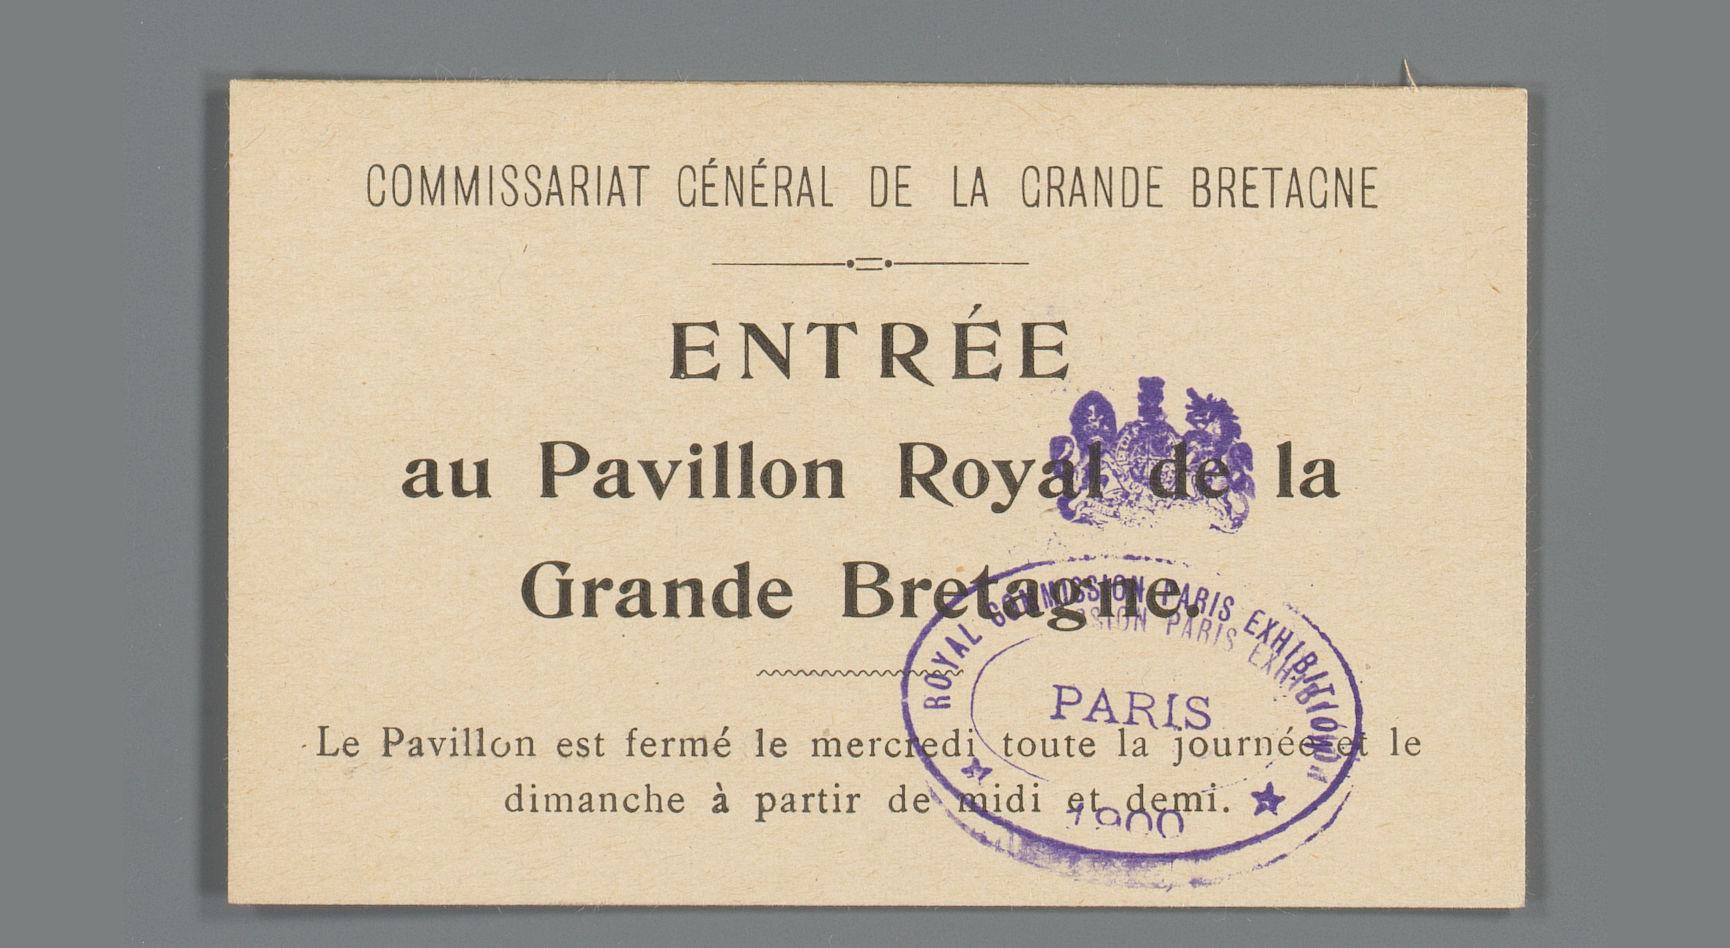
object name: photomechanical print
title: Entreebewijs voor het Engelse paviljoen op de Wereldtentoonstelling 1900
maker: Anonymous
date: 1900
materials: paper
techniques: printing block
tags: printed matter, paris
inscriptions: stamp: ‘[Wapen van het Verenigd Koninkrijk] Royal Commission Paris Exhibition 1900’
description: Kaart met de tekst: 'Commissariat général de la Grande Bretagne. Entrée au Pavillon Royal de la Grande Bretagne. Le Pavillon est fermé le mercredi toute la journée et le dimanche à partir de midi et demi'.